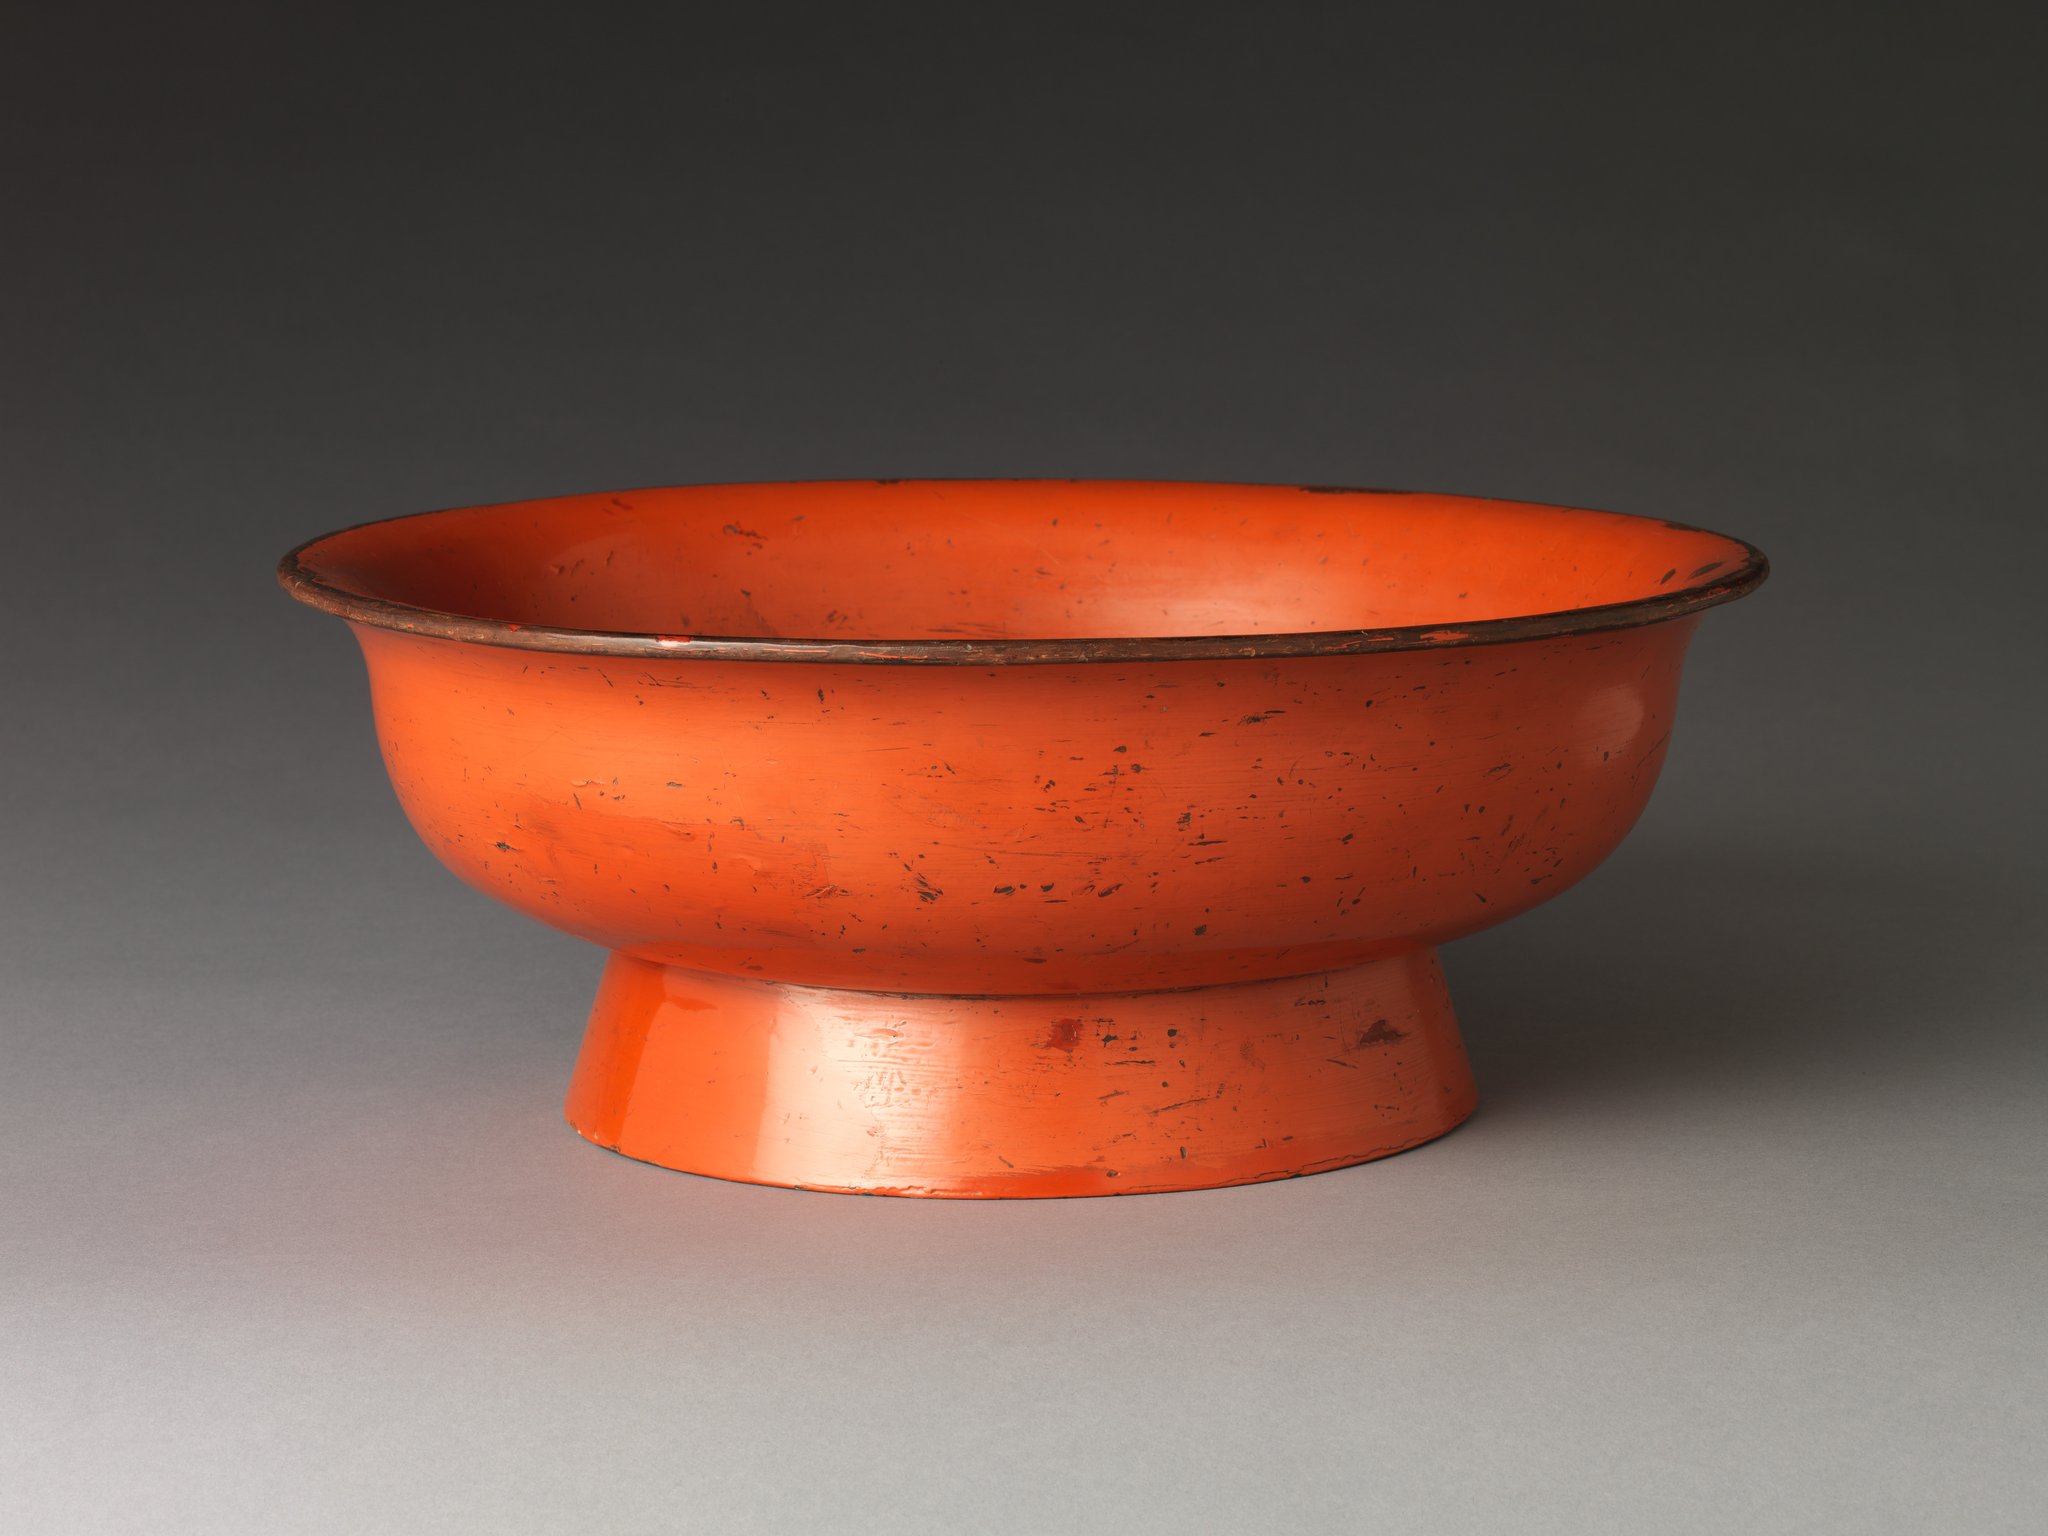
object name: bowl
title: Footed Bowl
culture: japanese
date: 1567-1633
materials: lacquer